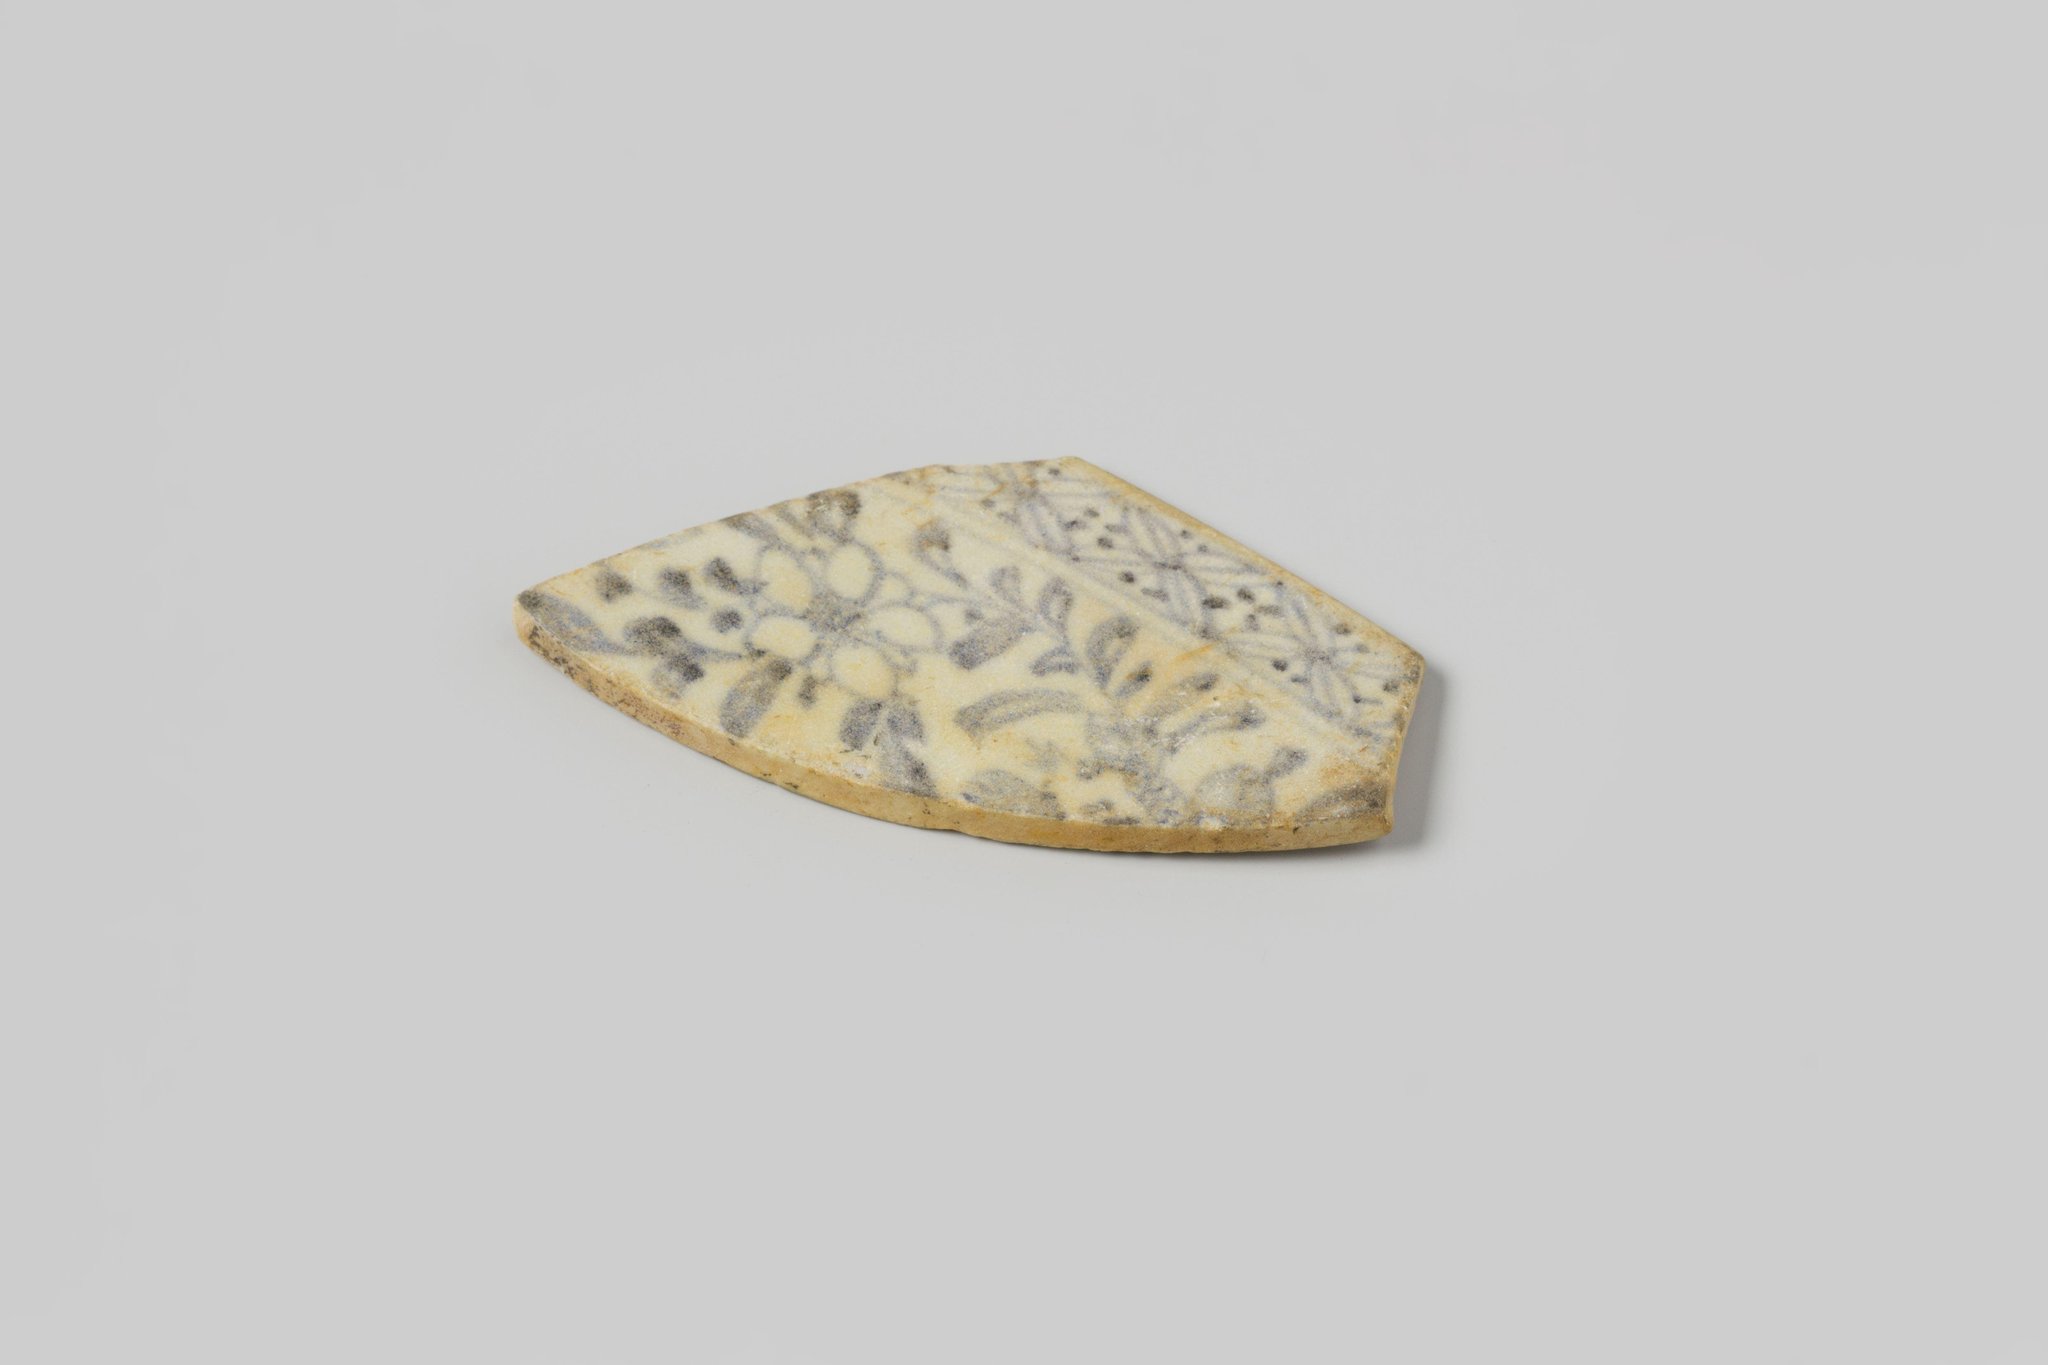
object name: plate dish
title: Scherf van een bord uit het wrak van de Oost-Indiëvaarder Hollandia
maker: Anonymous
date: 1700-1743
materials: porcelain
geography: netherlands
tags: verenigde oostindische compagnie, hollandia (schip), annet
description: Porcelain, plate, type 2; fragm of rim, sim. NG 1980-27H2624h.